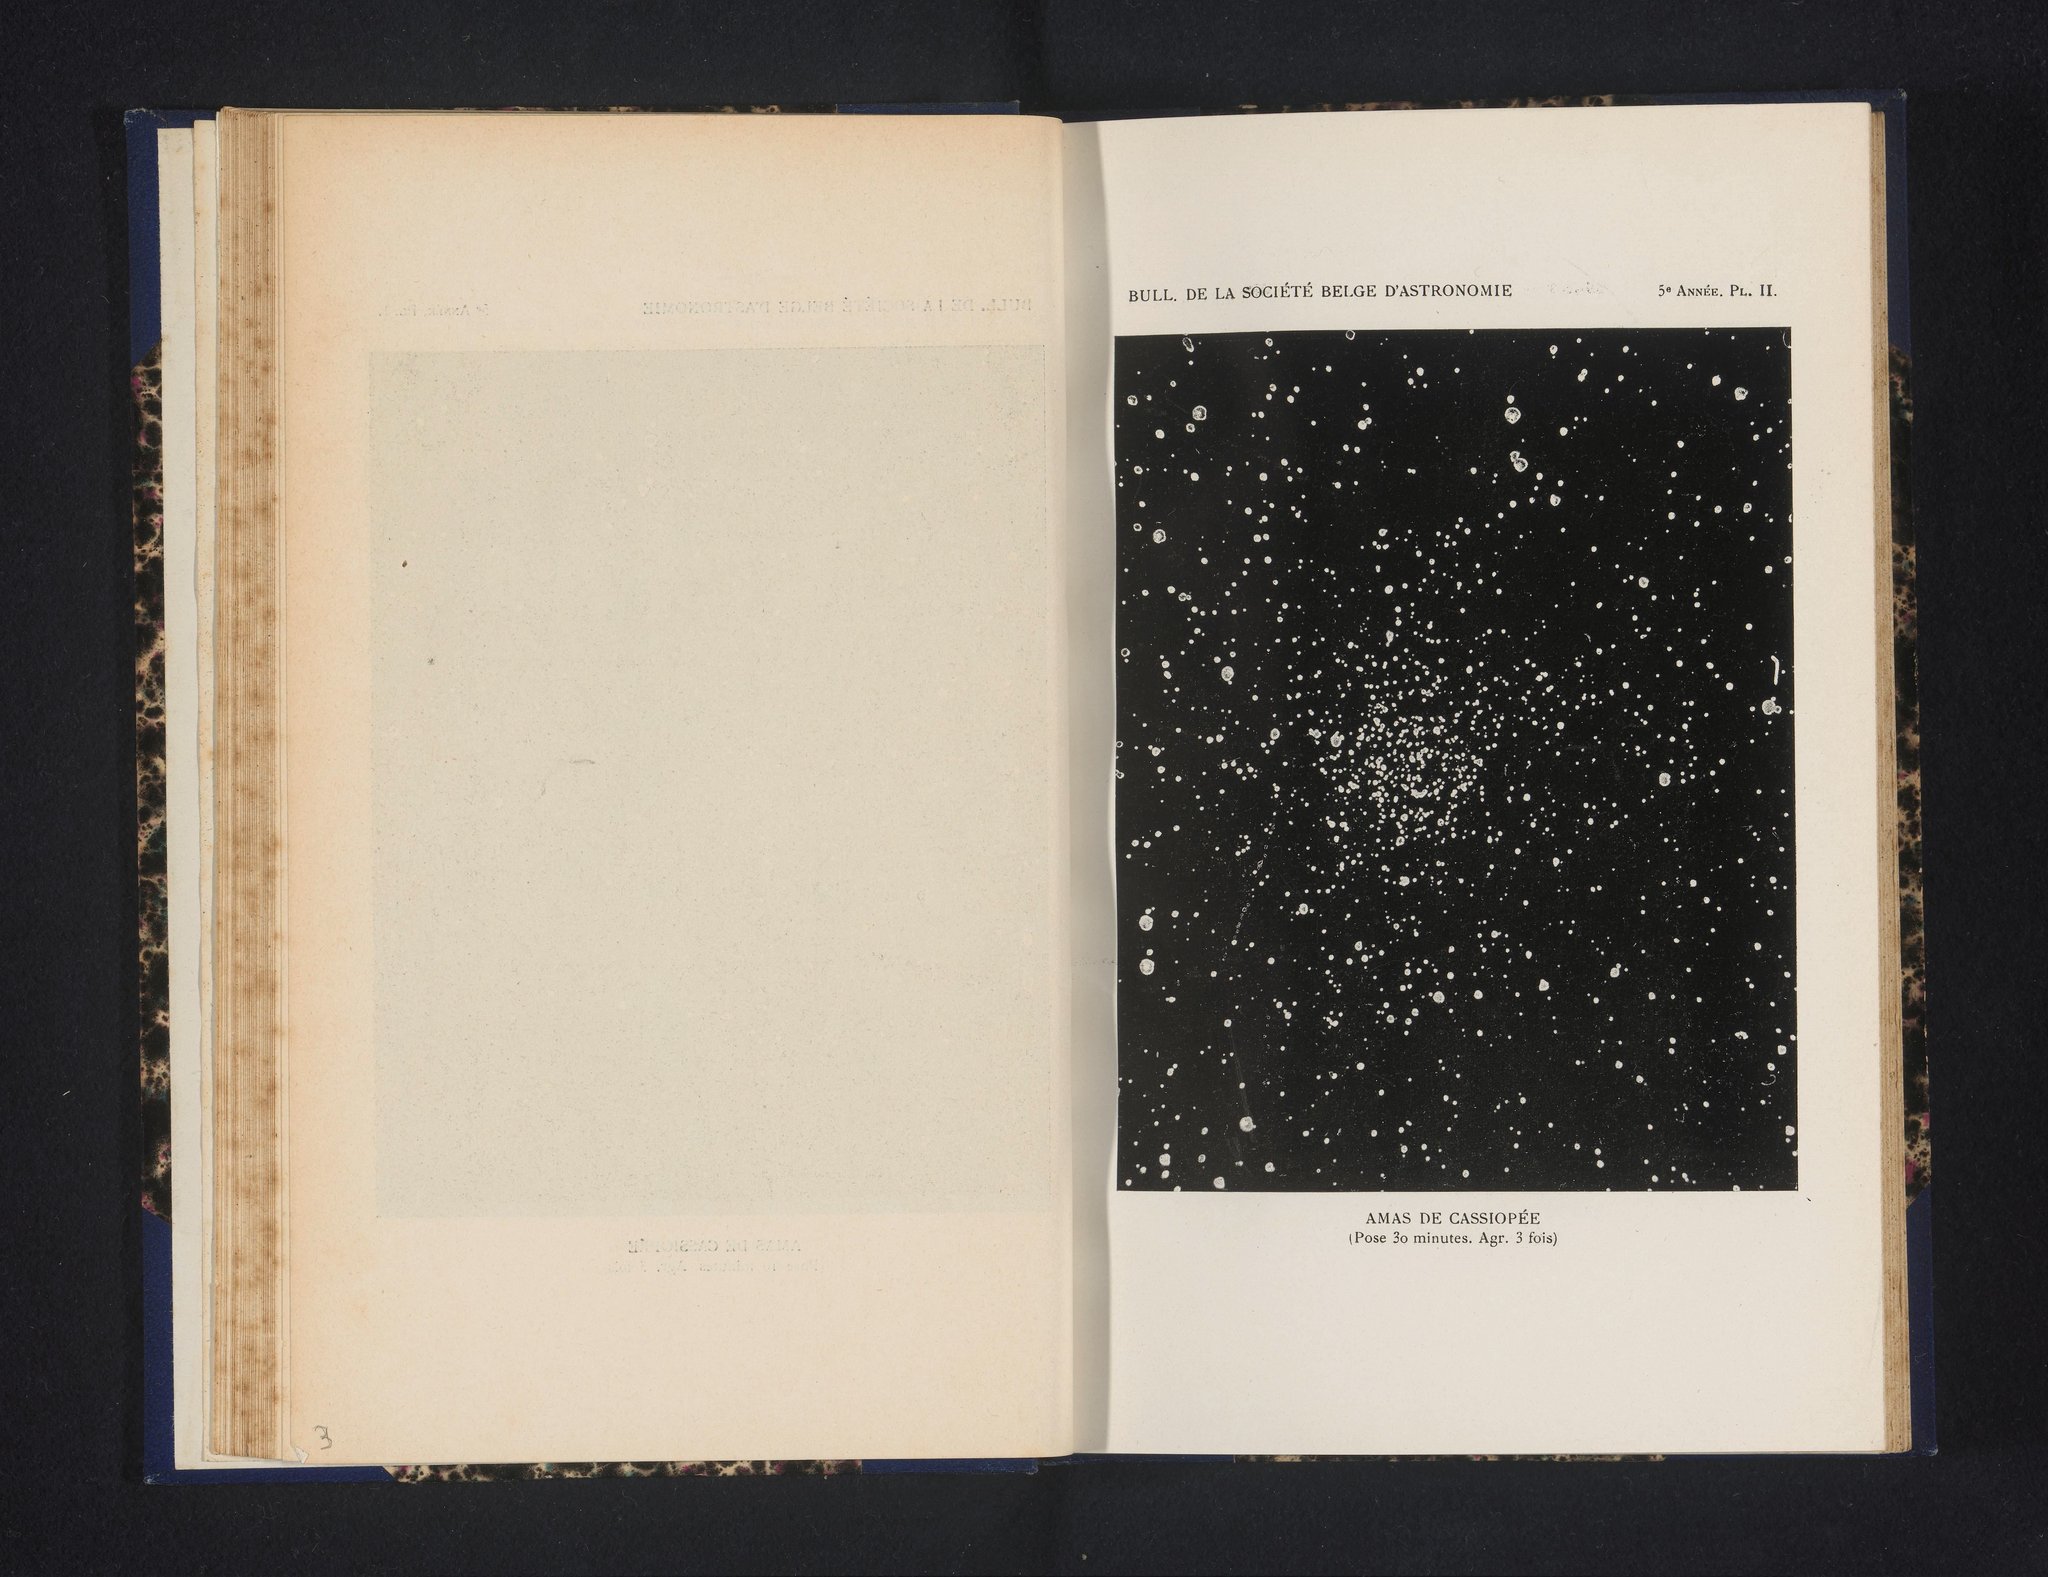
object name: photomechanical print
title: Sterrenbeeld Cassopeia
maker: Anonymous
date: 1895-1900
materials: paper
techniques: autotype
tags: stars and constellations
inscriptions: inscription: ‘Société Belge D'Astronomie 5e Année, Pl. II’, inscription: ‘Pose 30 minutes. Agr 3 fois.’